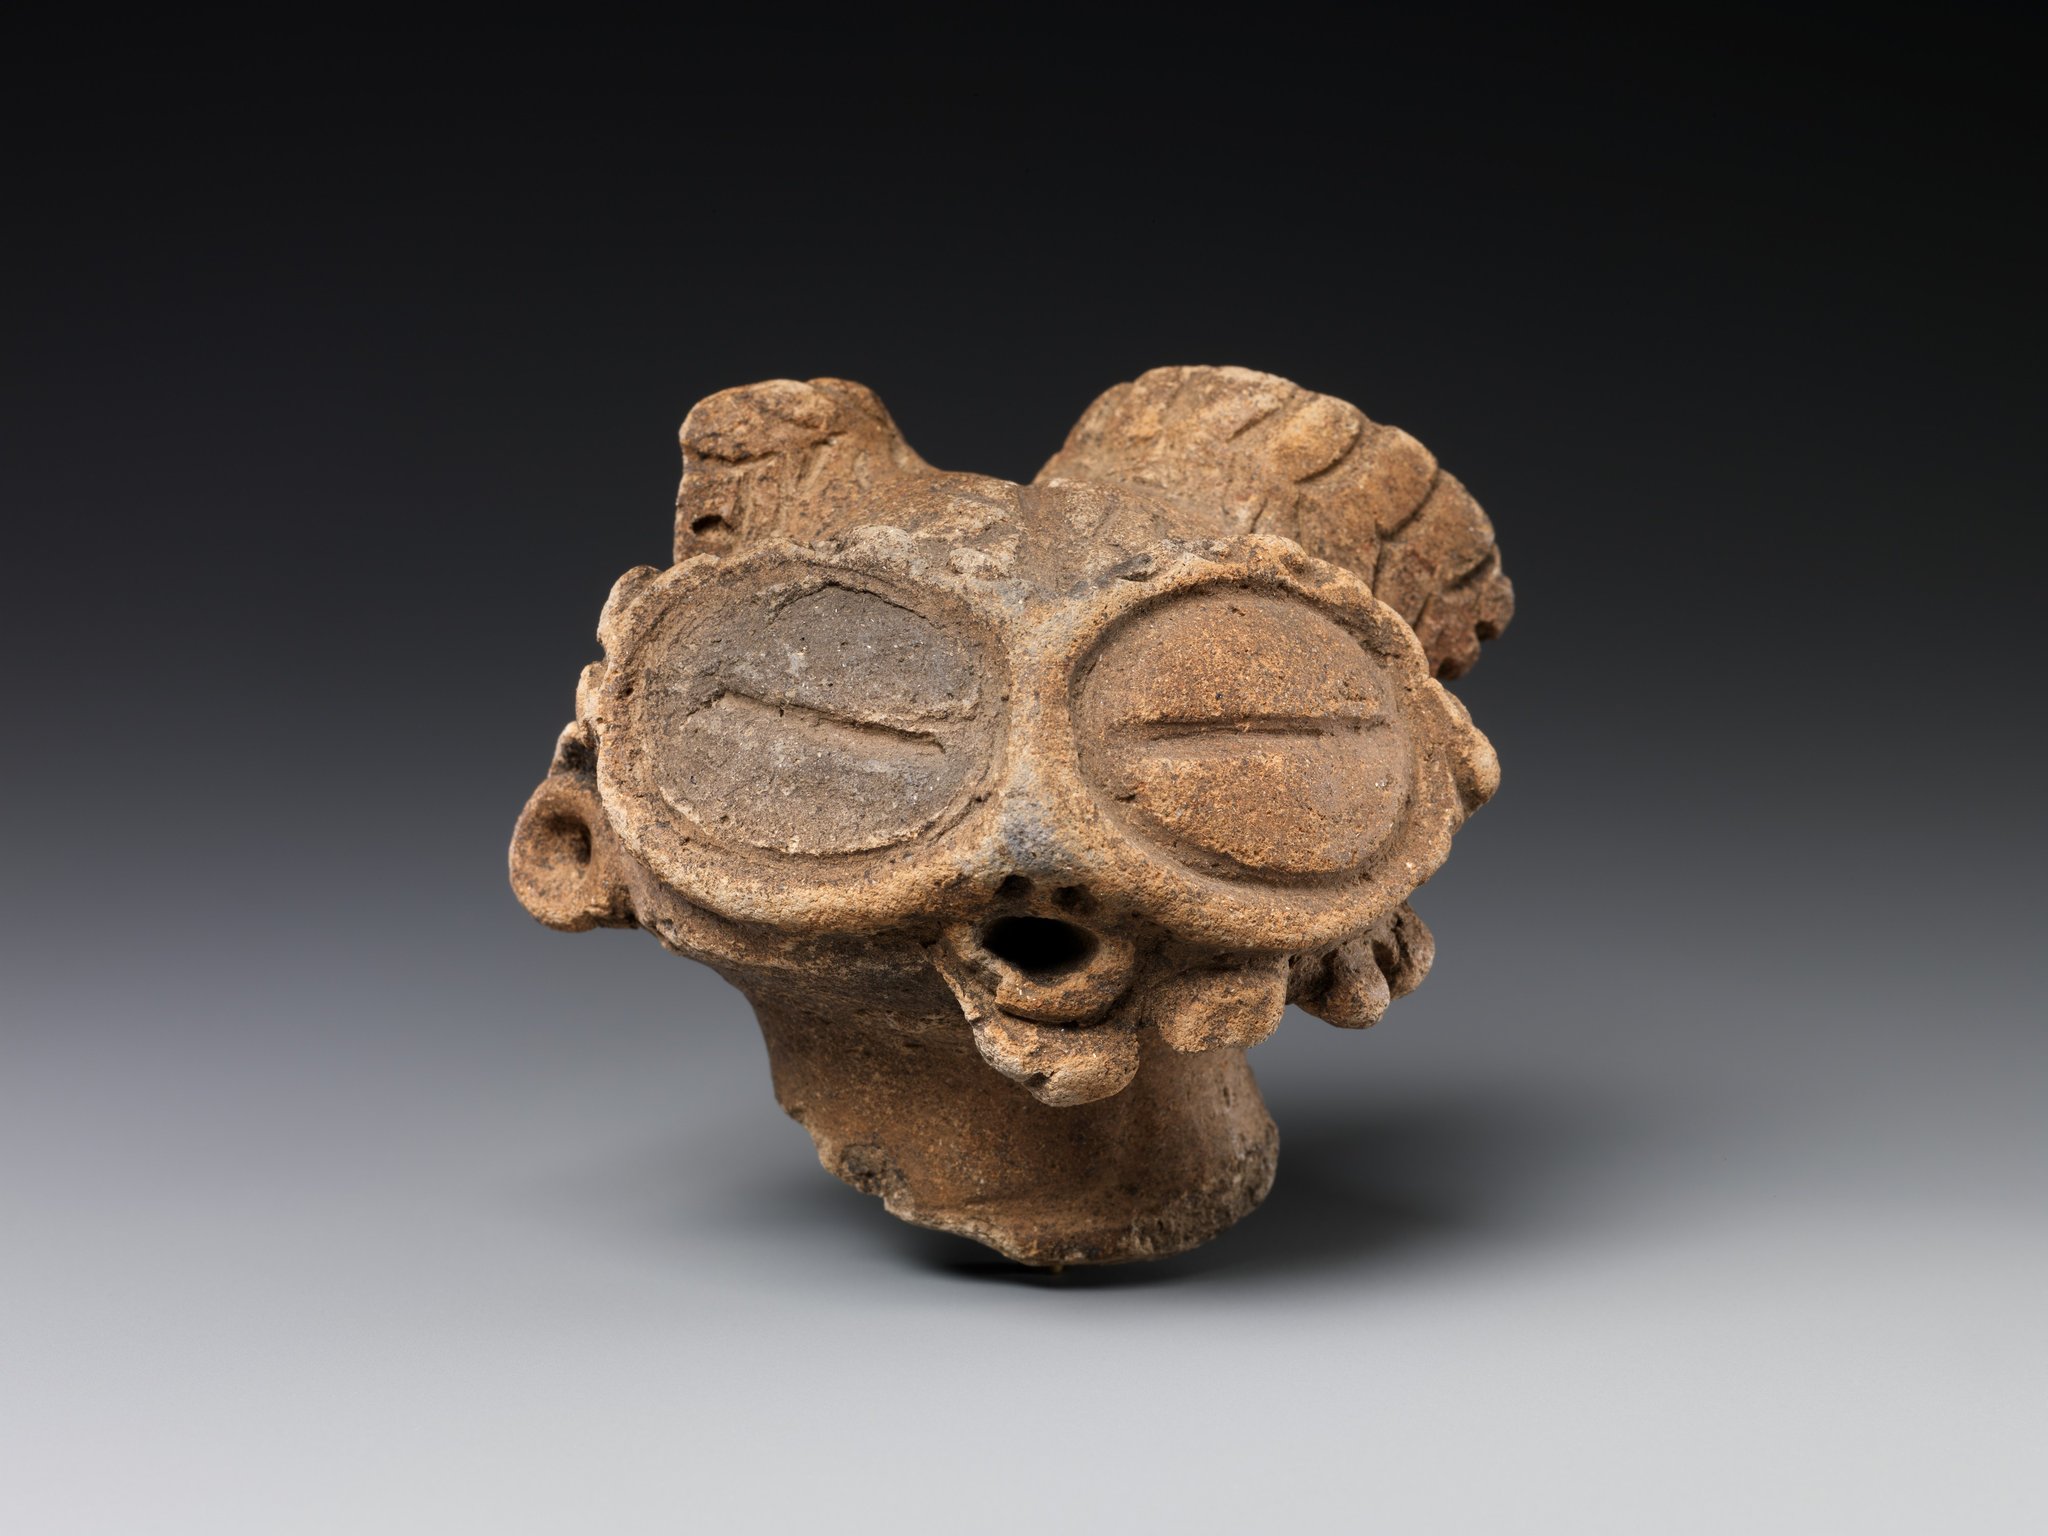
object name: head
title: Head of a Figure (Dogū)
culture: japanese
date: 1000-350 BCE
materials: cord, earthenware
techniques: incising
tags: animals